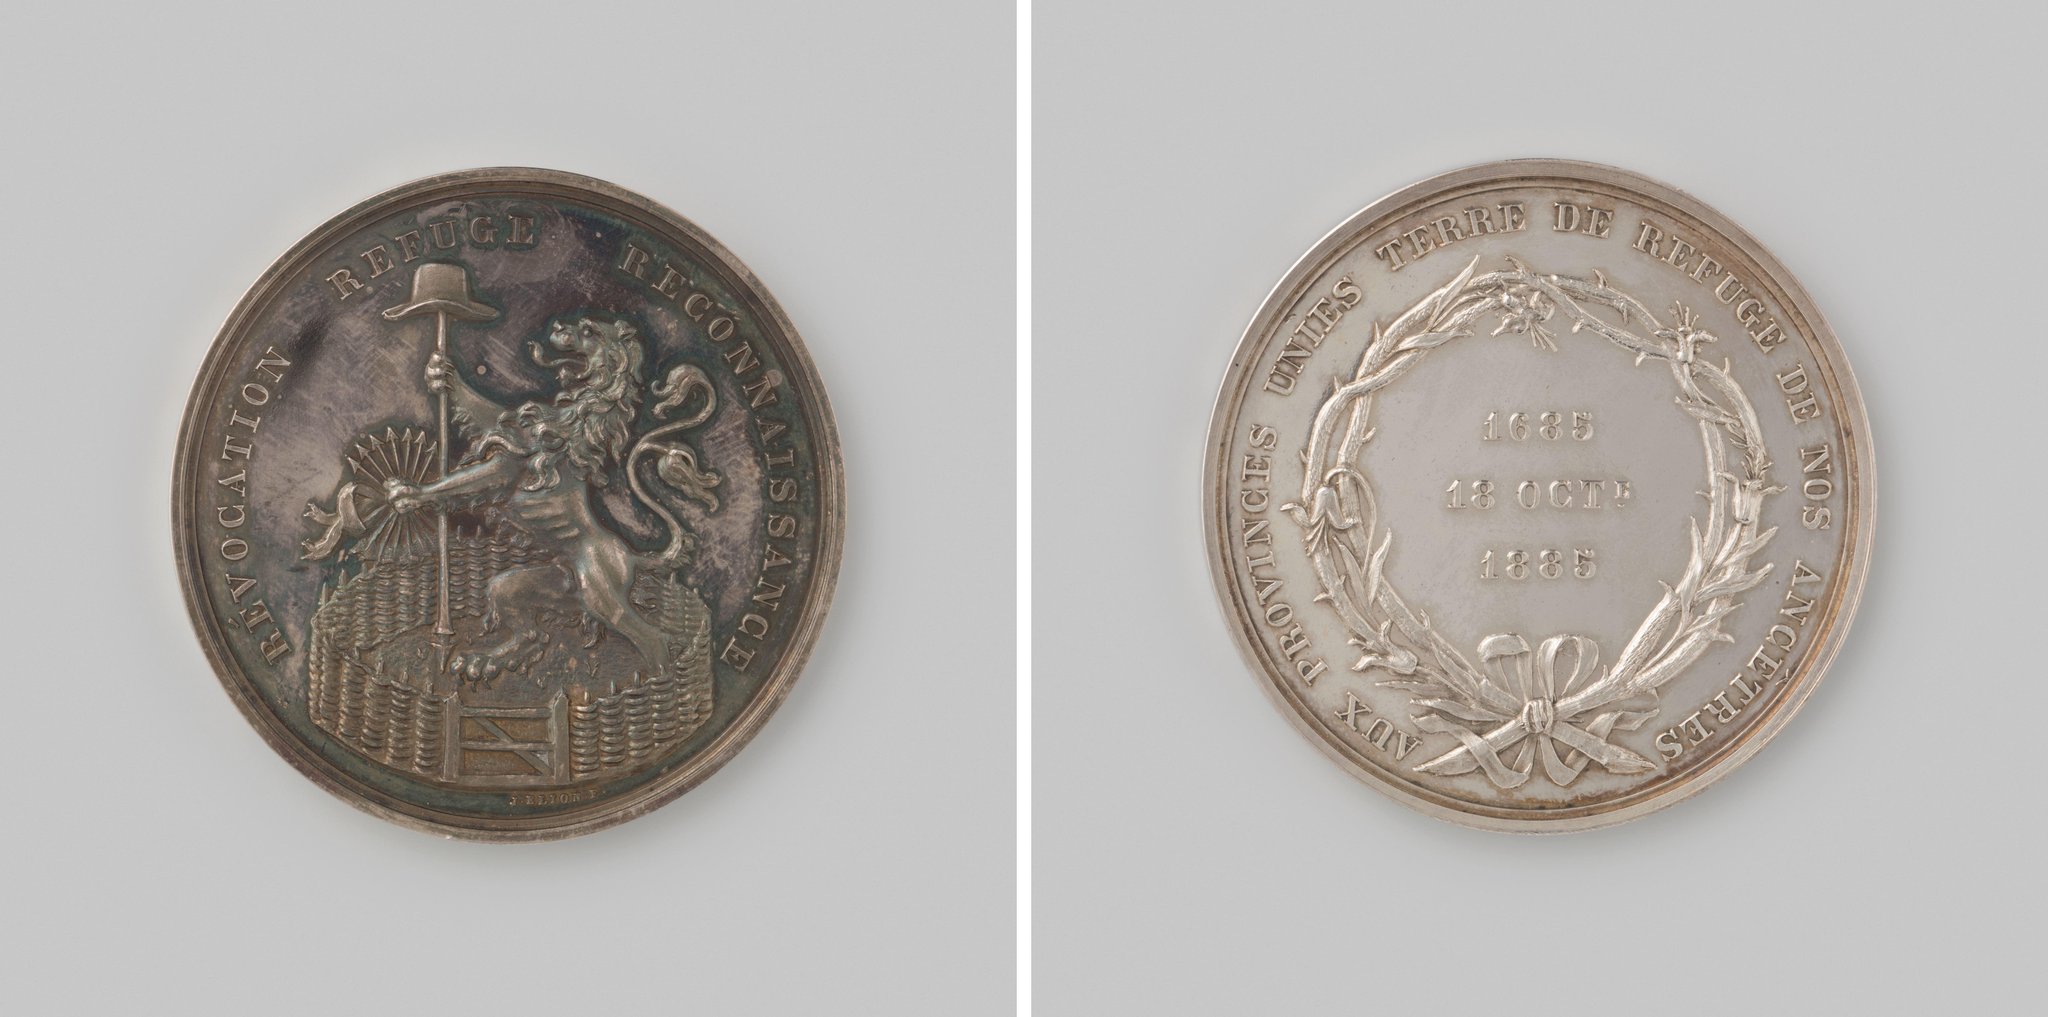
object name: history medal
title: Tweehonderdjarige herdenking van het herroepen van het Edict van Nantes 1885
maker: jacob samuel cohen elion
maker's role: draughtsman, painter, print maker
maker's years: 1840-1893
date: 1885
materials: silver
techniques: striking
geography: amsterdam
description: Zilveren penning, op de voorzijde een klimmende leeuw met pijlenbundel en lans met vrijheidshoed in de Hollandse Tuin, met omschrift, op de keerzijde drie regels tekst tussen samengestrikte doorn- en lelietakken, met omschrift.